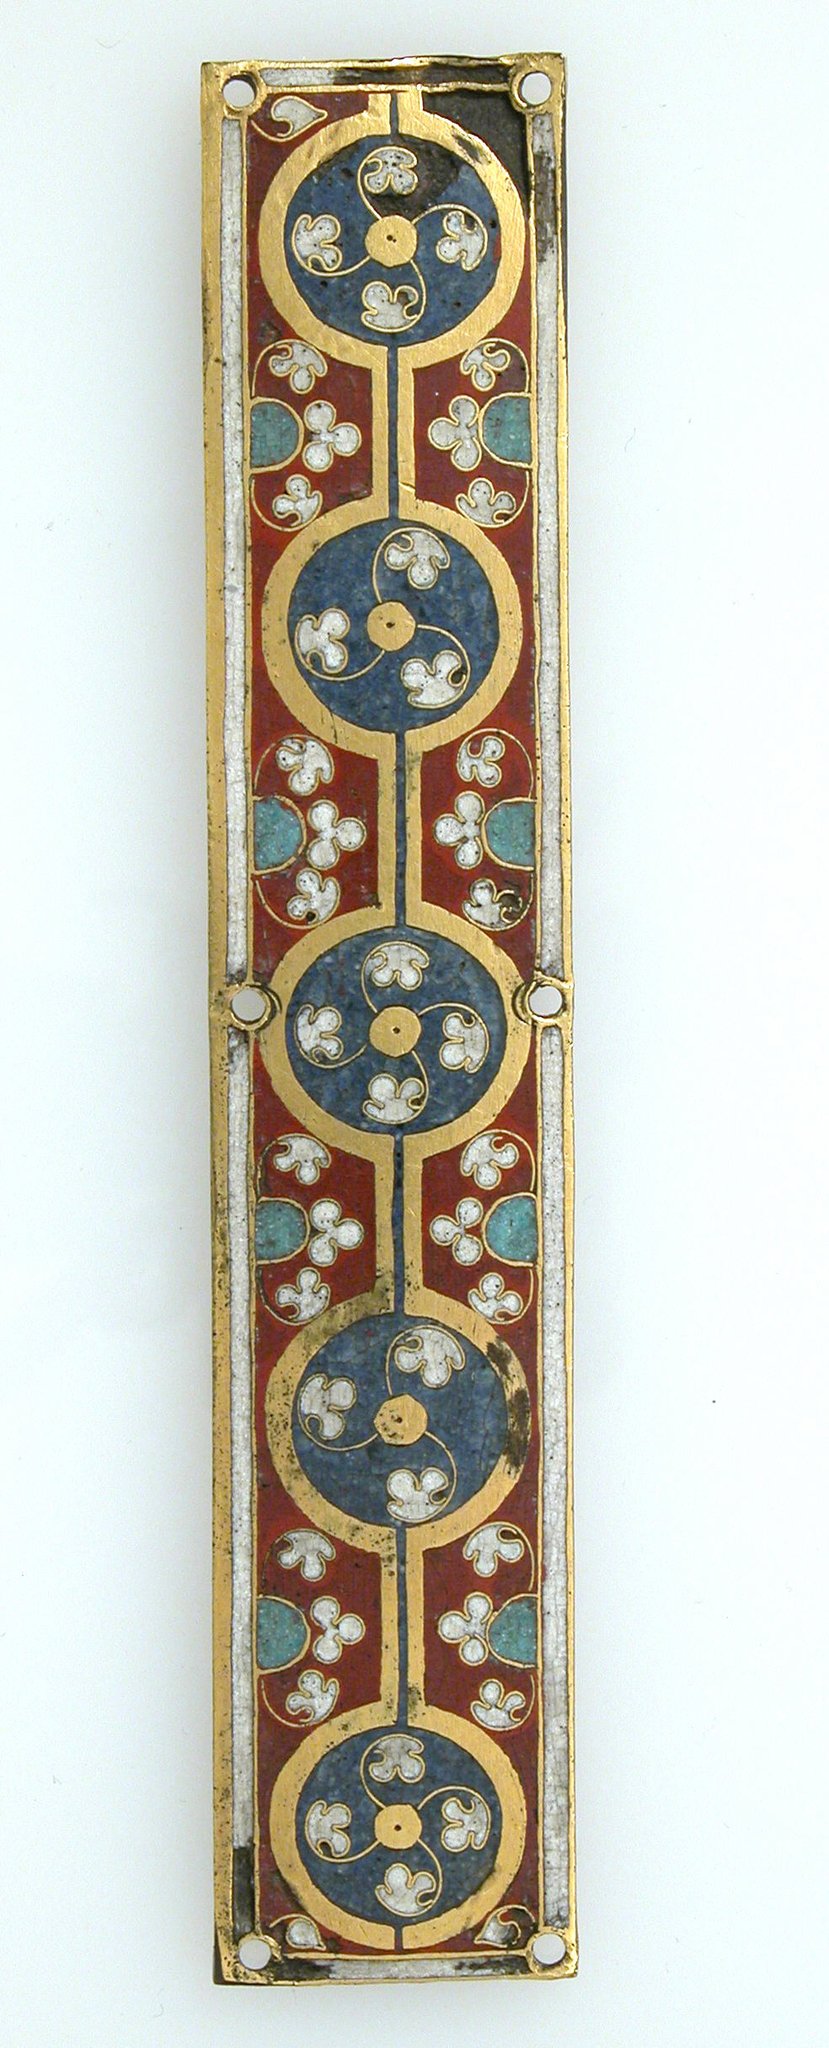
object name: plaque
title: Plaque from a Reliquary Shrine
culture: german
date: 1186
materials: copper alloy, enamel, gilt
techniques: enamel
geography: germany